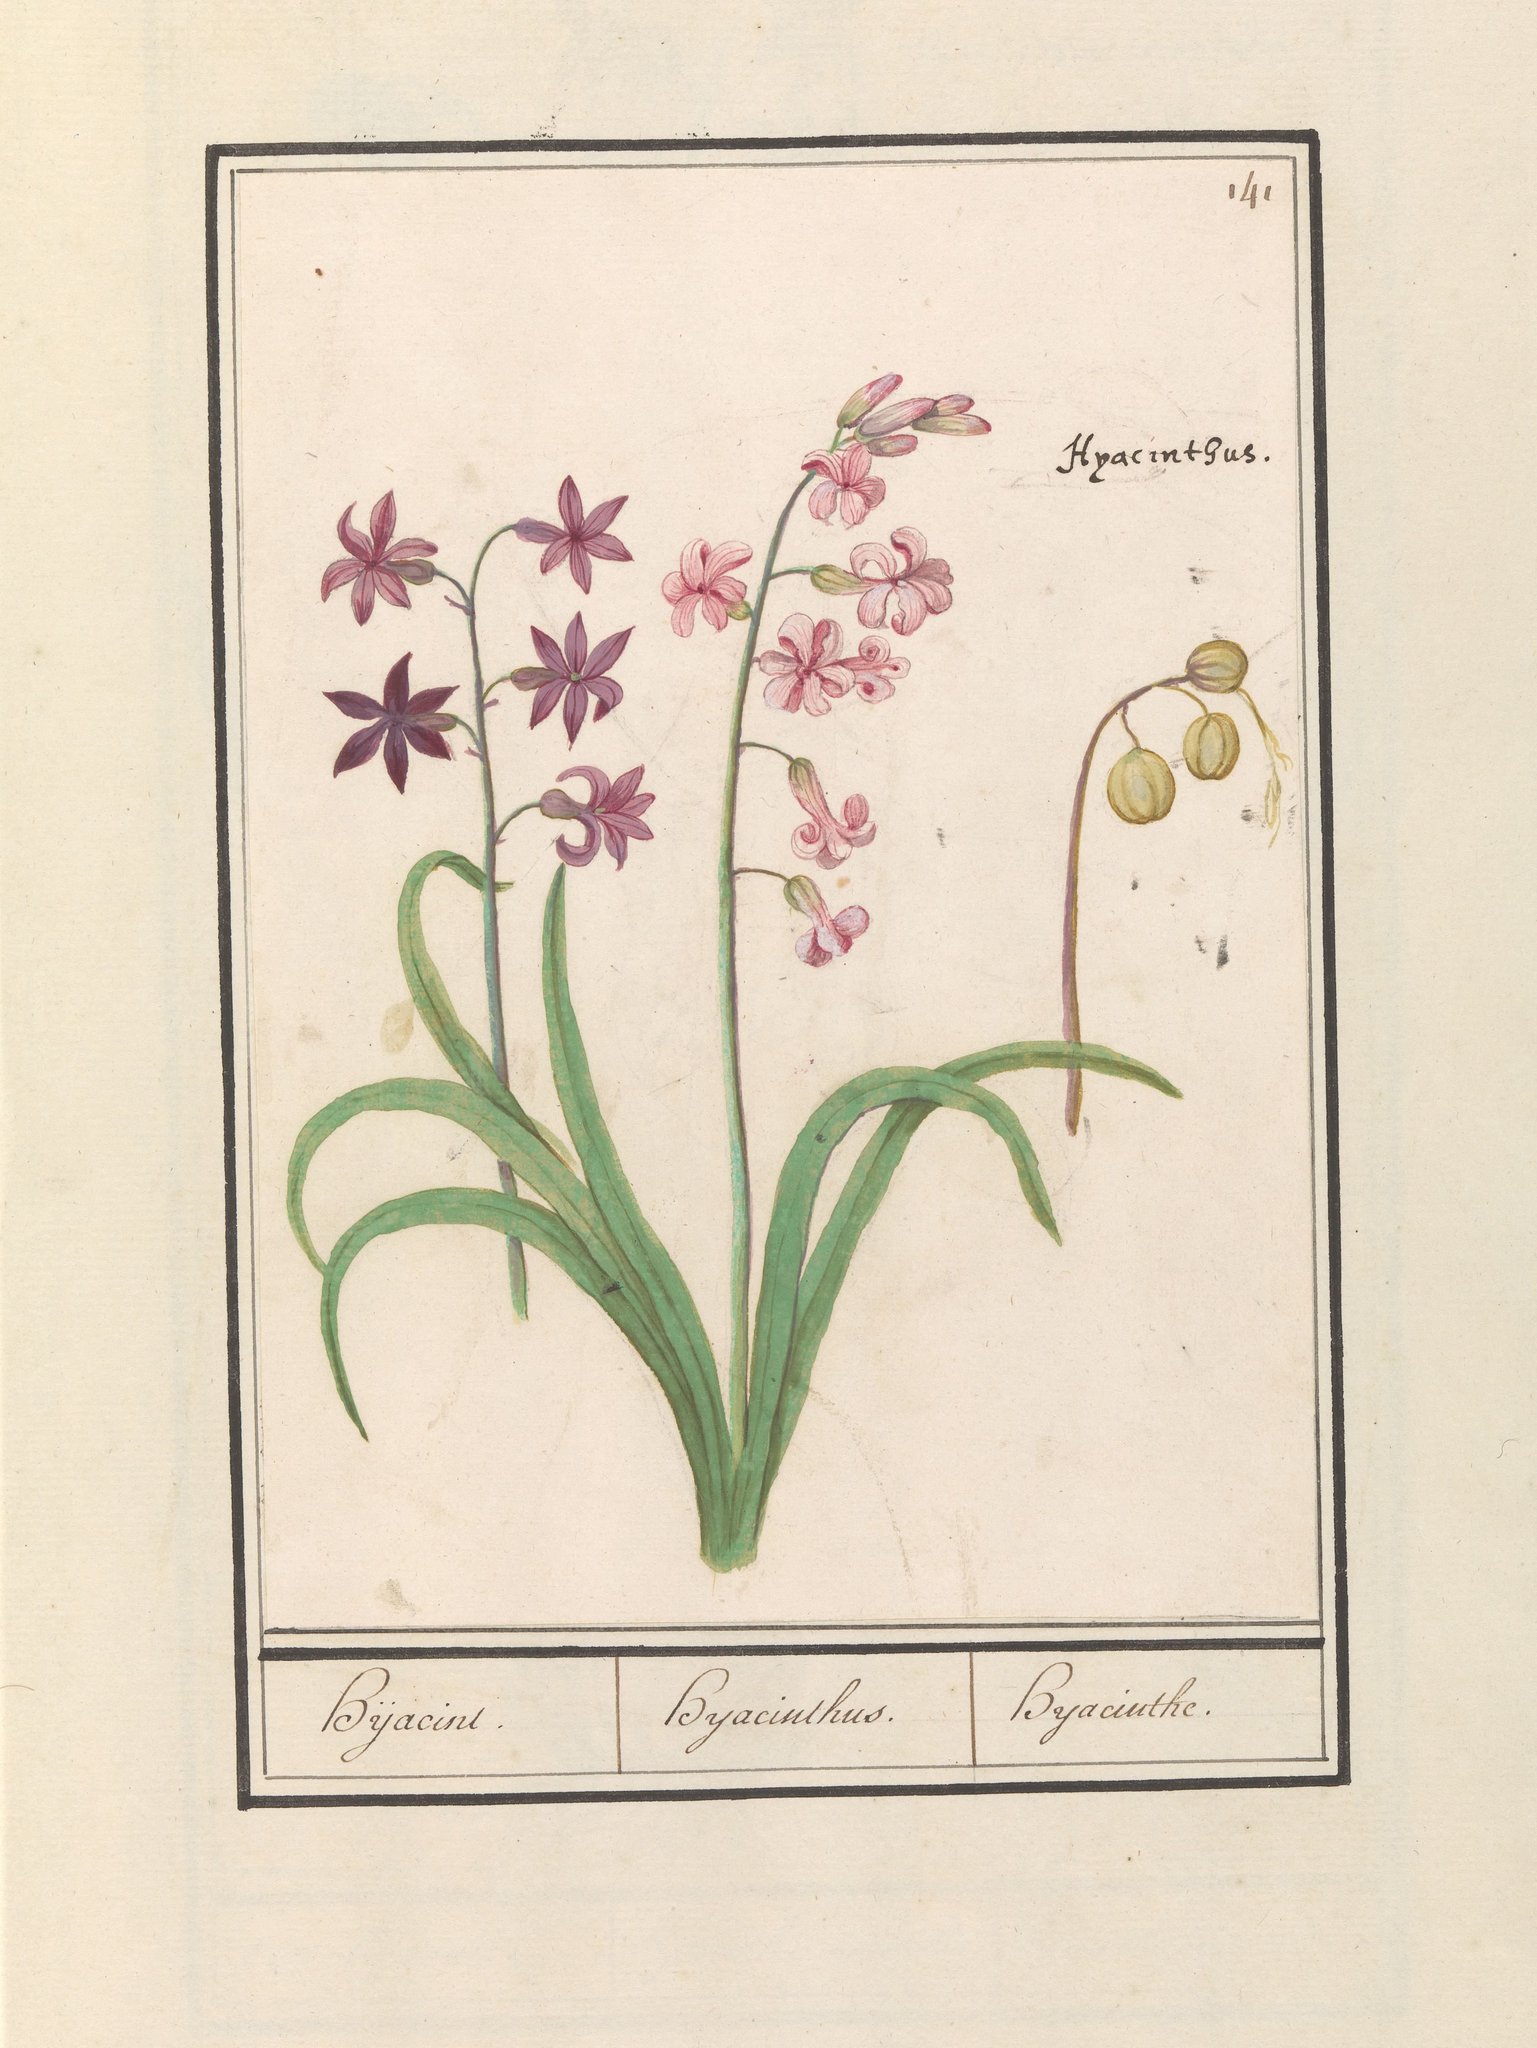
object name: drawing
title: Hijacint. / Hijacinthus. / Hyacinthe.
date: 1596-1610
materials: chalk, paint, ink, paper, watercolor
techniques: brush, pen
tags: flowers: hyacinth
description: Roze hyacinten. Rechtsboven genummerd: 141. Rechtsboven de Latijnse namen. Onderdeel van het tweede album met tekeningen van bloemen en planten. Negende van twaalf albums met tekeningen van dieren, vogels en planten bekend rond 1600, gemaakt in opdracht van keizer Rudolf II. Met toelichting in Nederlands, Latijn en Frans.